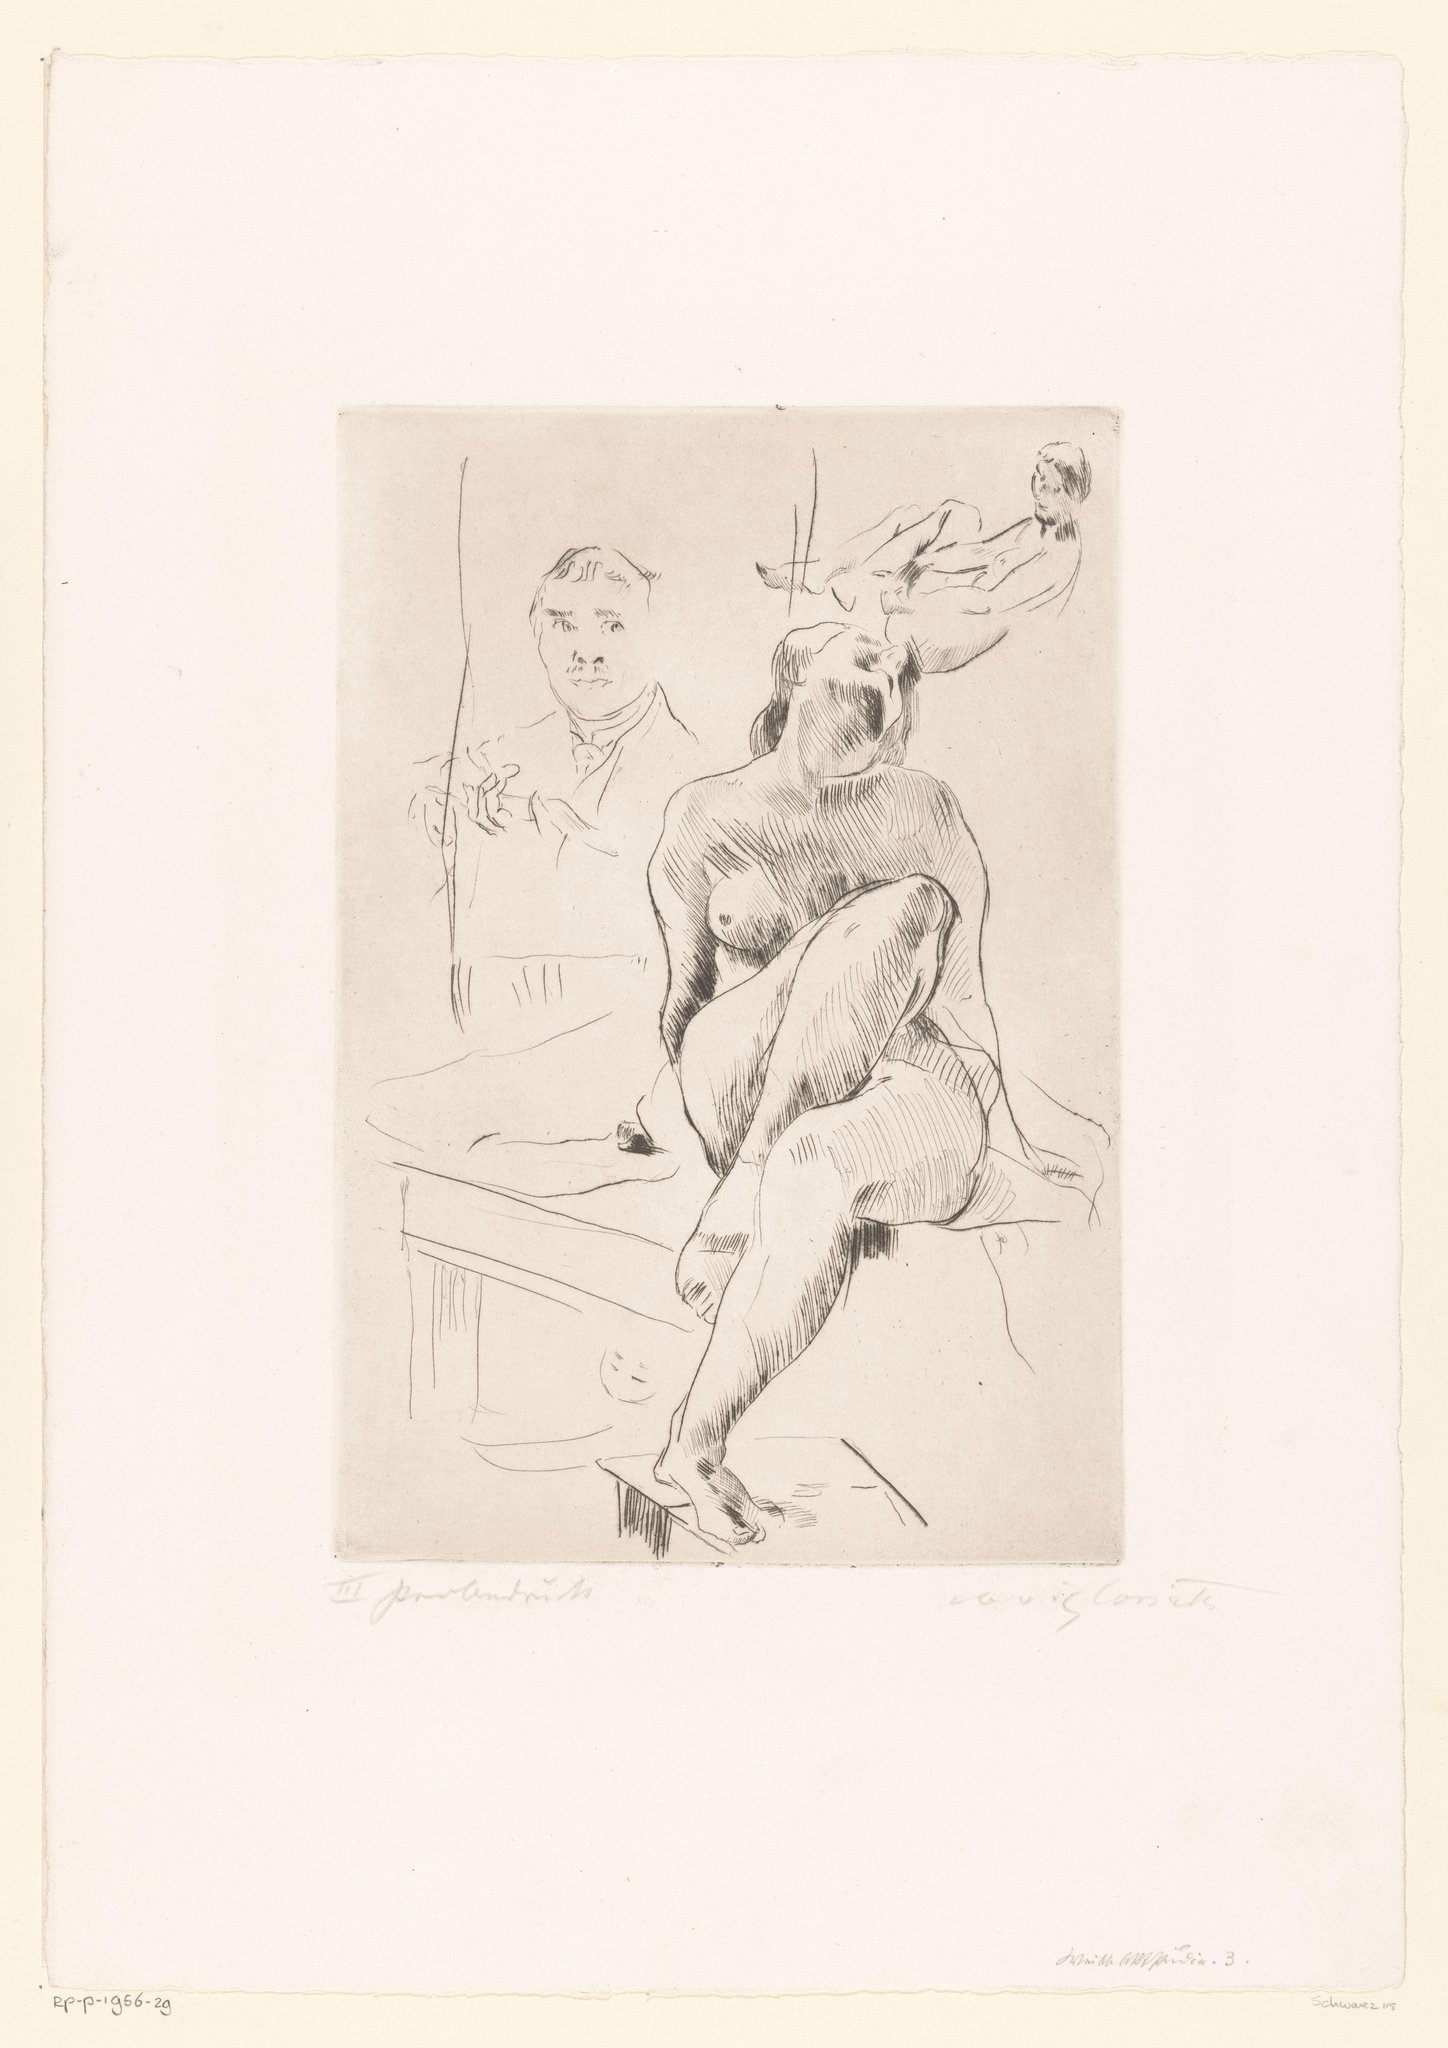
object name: print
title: Twee naakten met zelfportret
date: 1913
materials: paper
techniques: drypoint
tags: lovis corinth, woman (showing herself) undressed, quasi-nude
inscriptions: collector's mark: Lugt 2760, inscription: ‘III Probendruck’, collector's mark: Lugt 2228